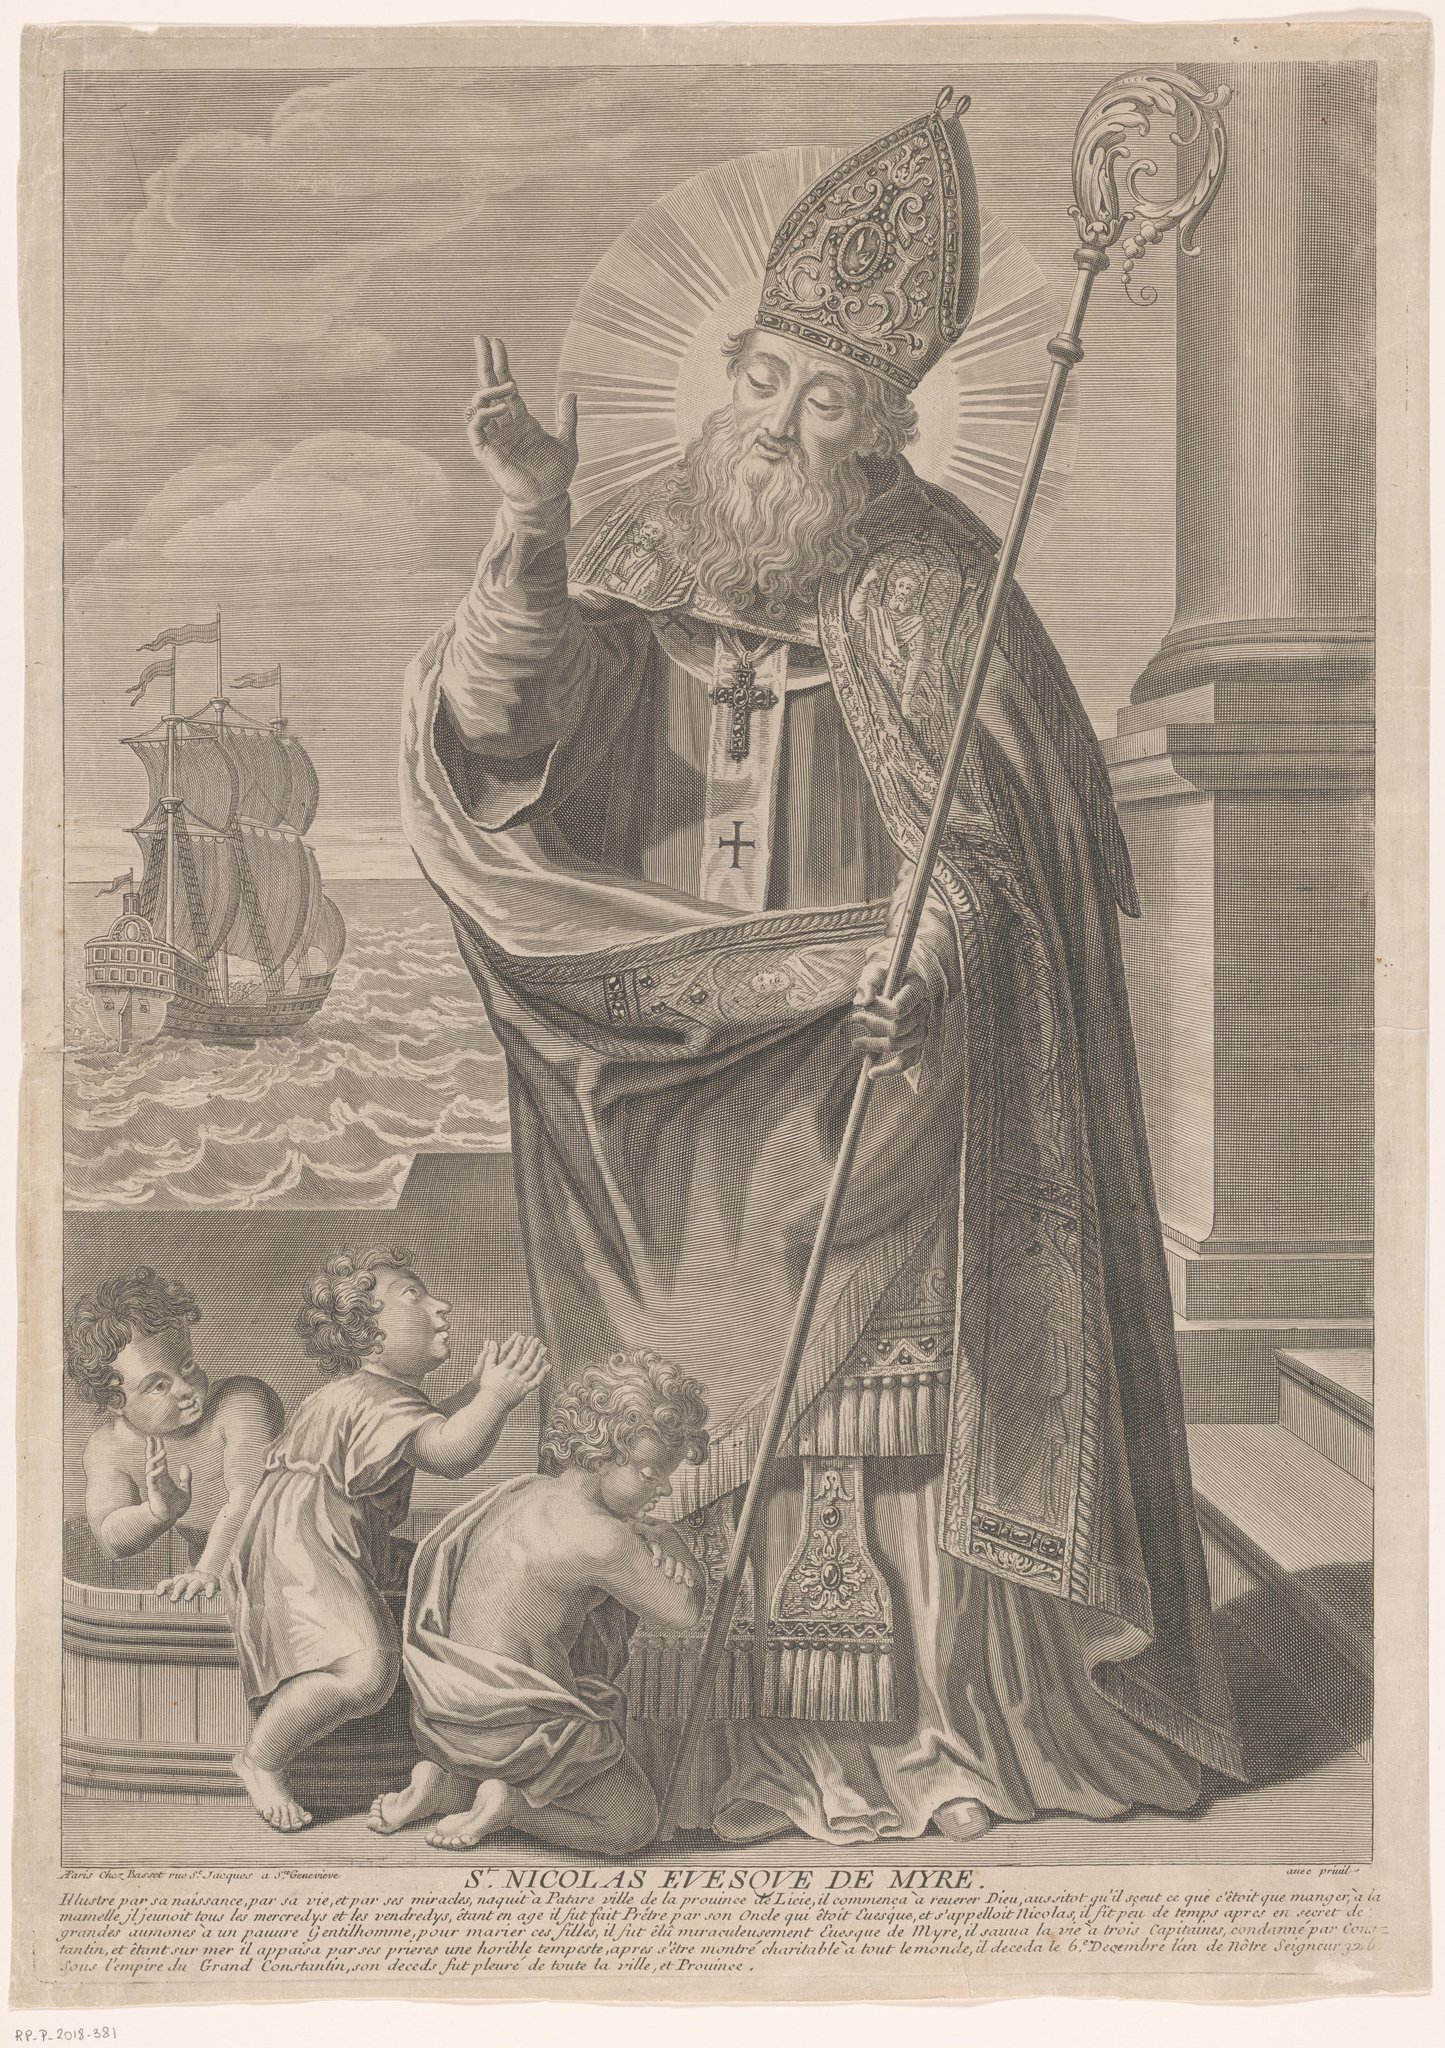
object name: print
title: Sint Nicolaas wekt drie kinderen tot leven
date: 1600-1699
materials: paper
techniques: engraving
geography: france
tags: sailing-ship, sailing-boat, st. nicholas restores to life three children who had been murdered, dismembered, and salted down in a pickling tub by an inn-keeper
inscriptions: collector's mark: Lugt 2228, collector's mark: Lugt 2760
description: De Heilige Nicolaas, voorgesteld als bisschop van Myra, maakt een zegenend gebaar naar drie kleine kinderen die uit een tobbe kruipen. Zij waren door een slager vermoord, in een tobbe gestopt en gepekeld. Sint Nicolaas bracht ze weer tot leven. Op de achtergrond een zee met een schip.